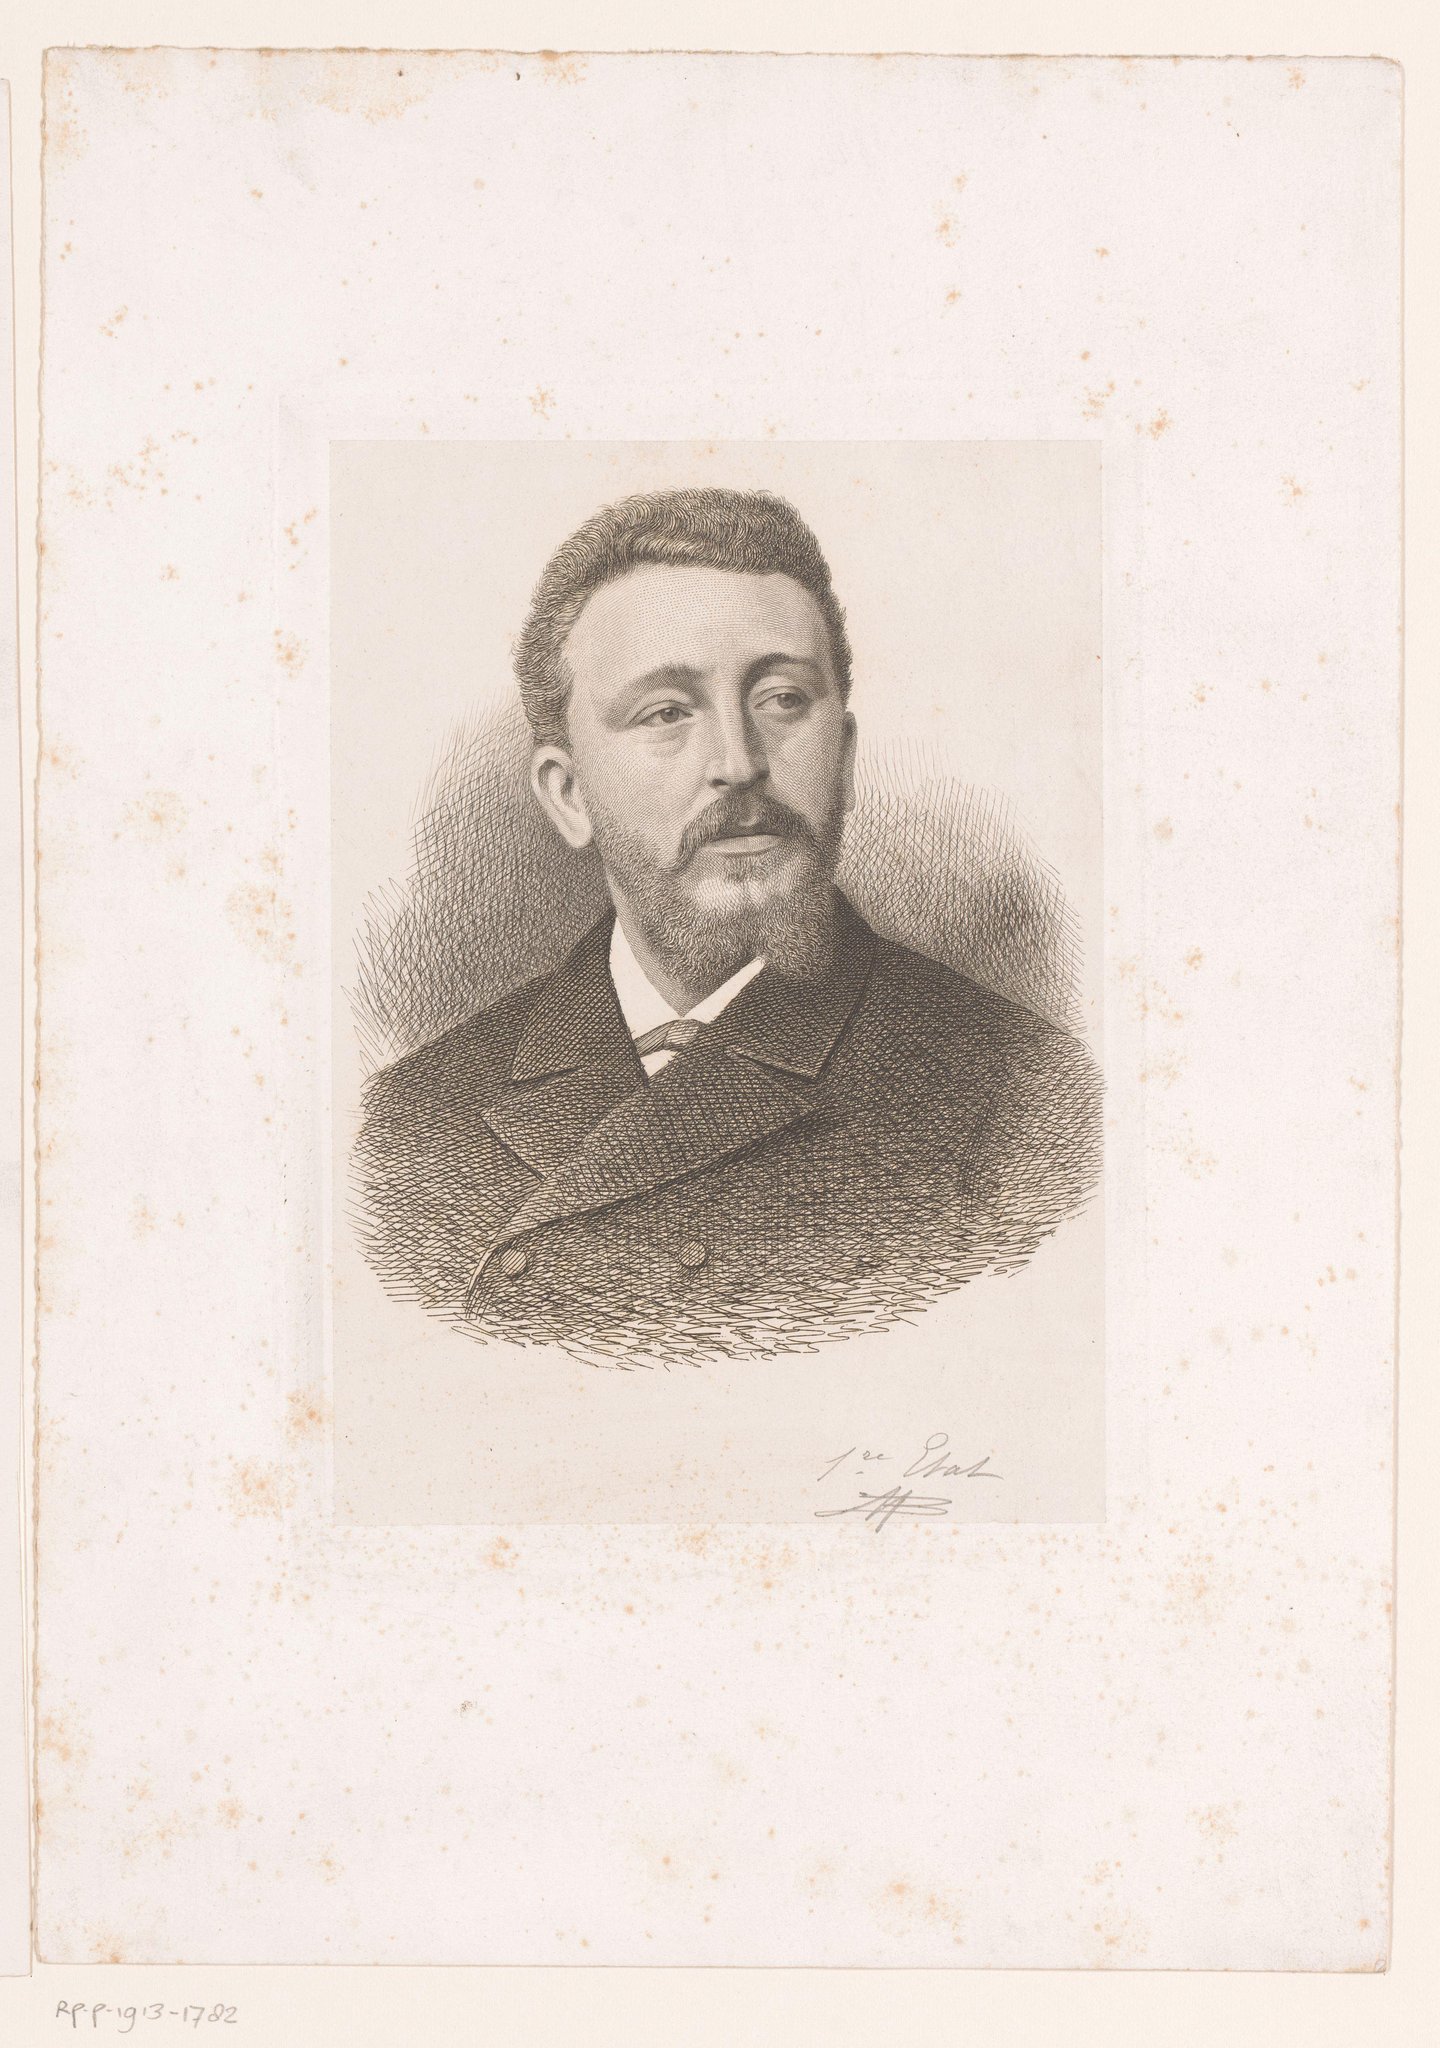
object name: print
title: Portret van M. Denis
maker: jean baptiste pierre michiels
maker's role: print maker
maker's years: 1821-1890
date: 1831-1890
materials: paper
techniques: etching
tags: historical persons, beard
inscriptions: collector's mark: Lugt 2228